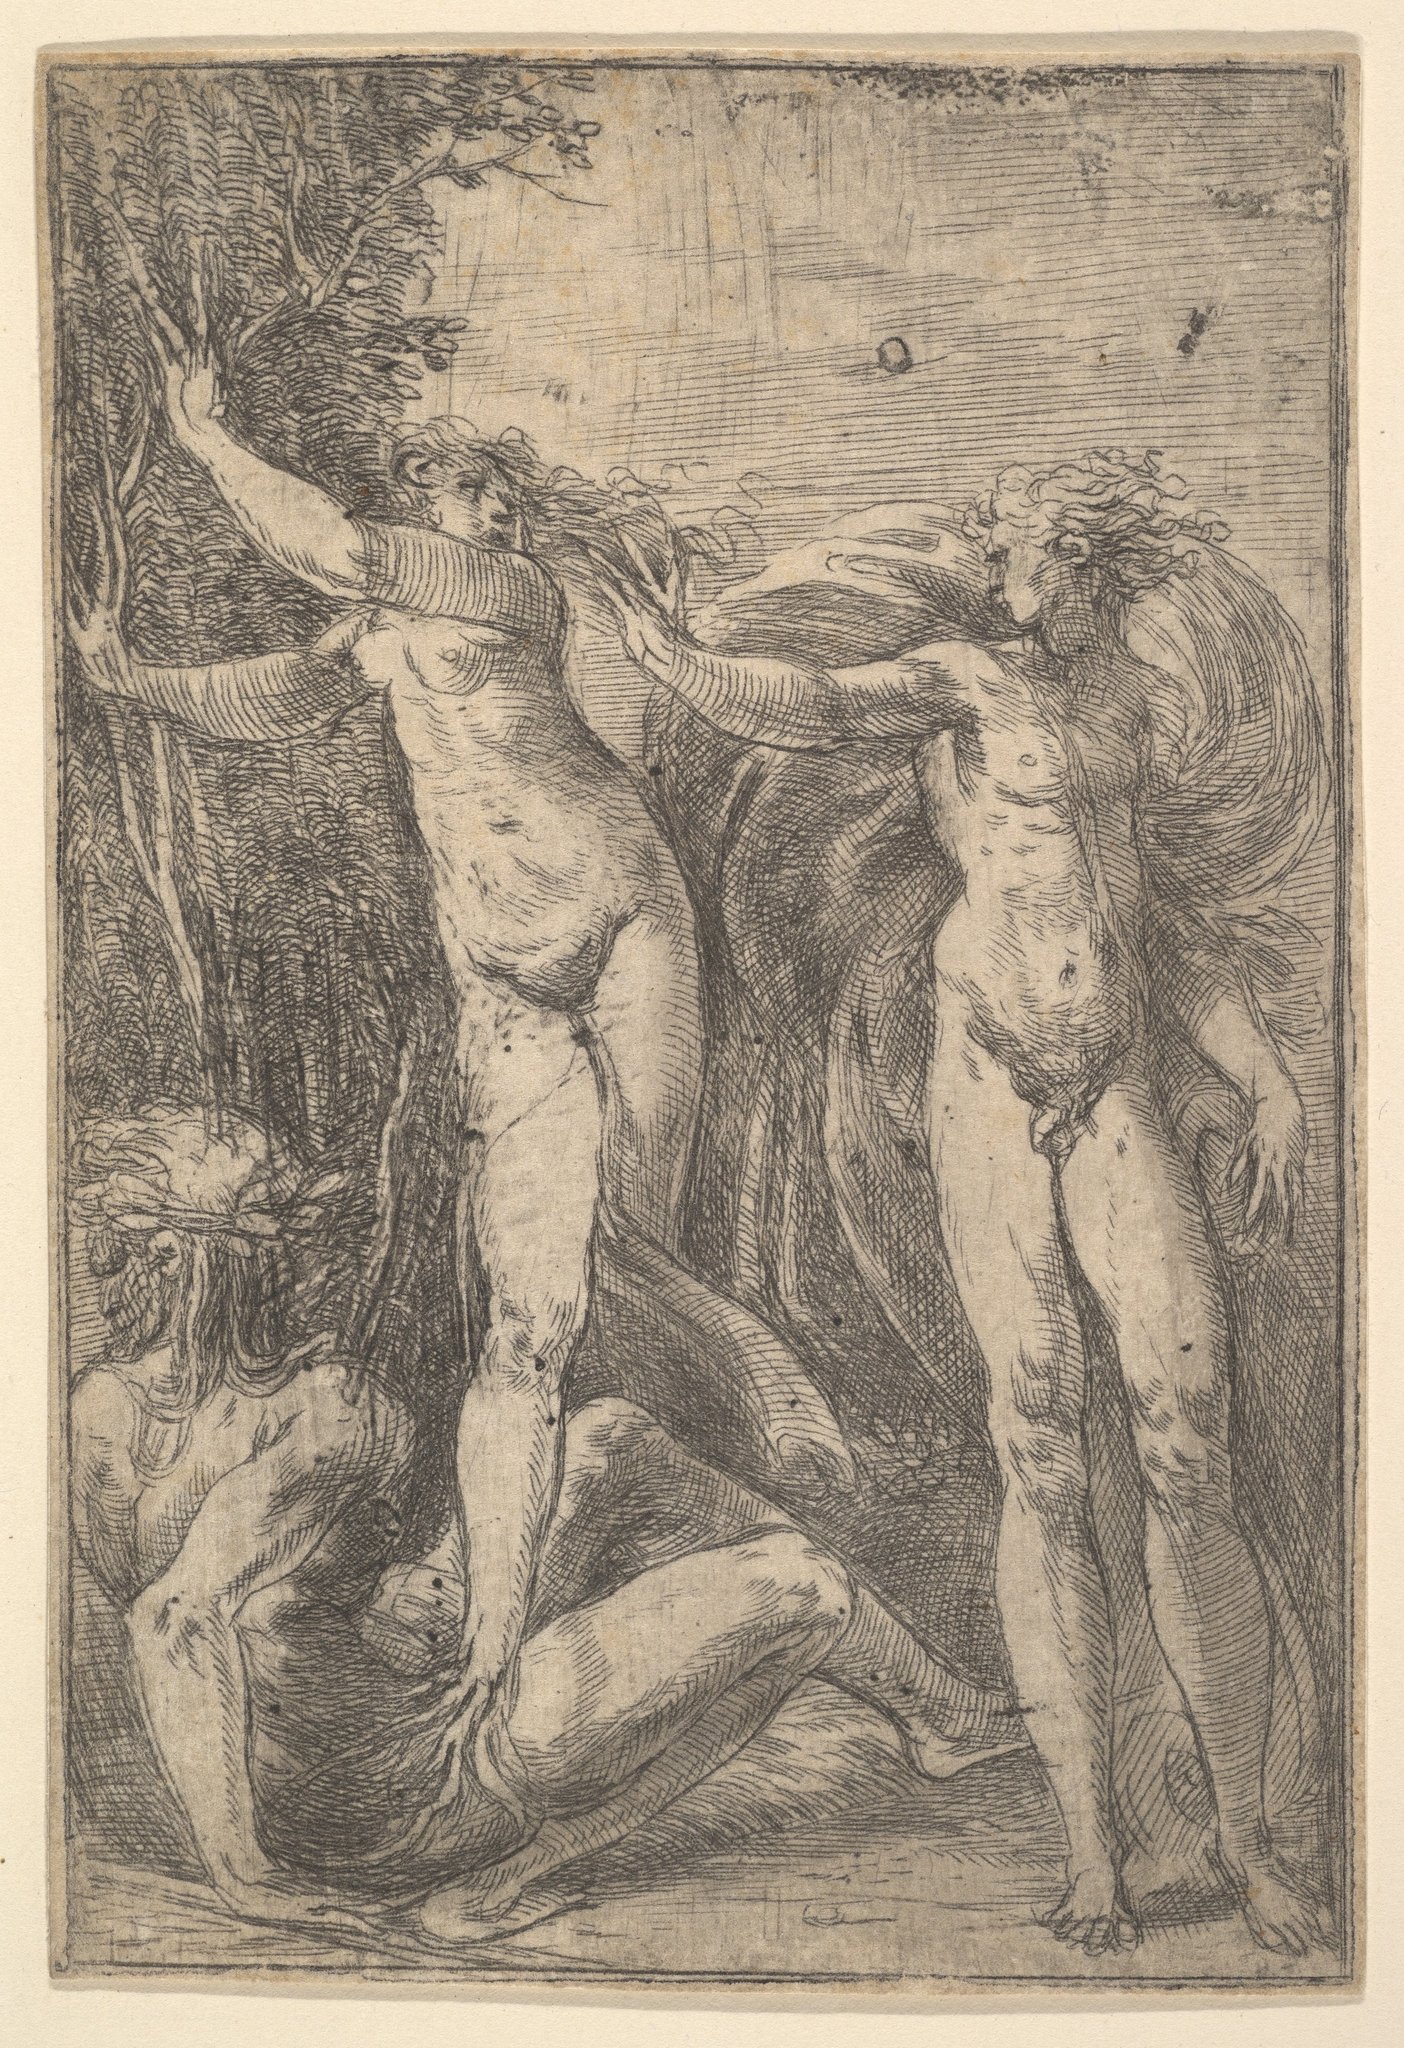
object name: print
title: Apollo and Daphne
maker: andrea schiavone (andrea meldola)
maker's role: artist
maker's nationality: italian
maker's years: 1510-1563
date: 1538-1540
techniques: etching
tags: male nudes,female nudes,apollo,daphne